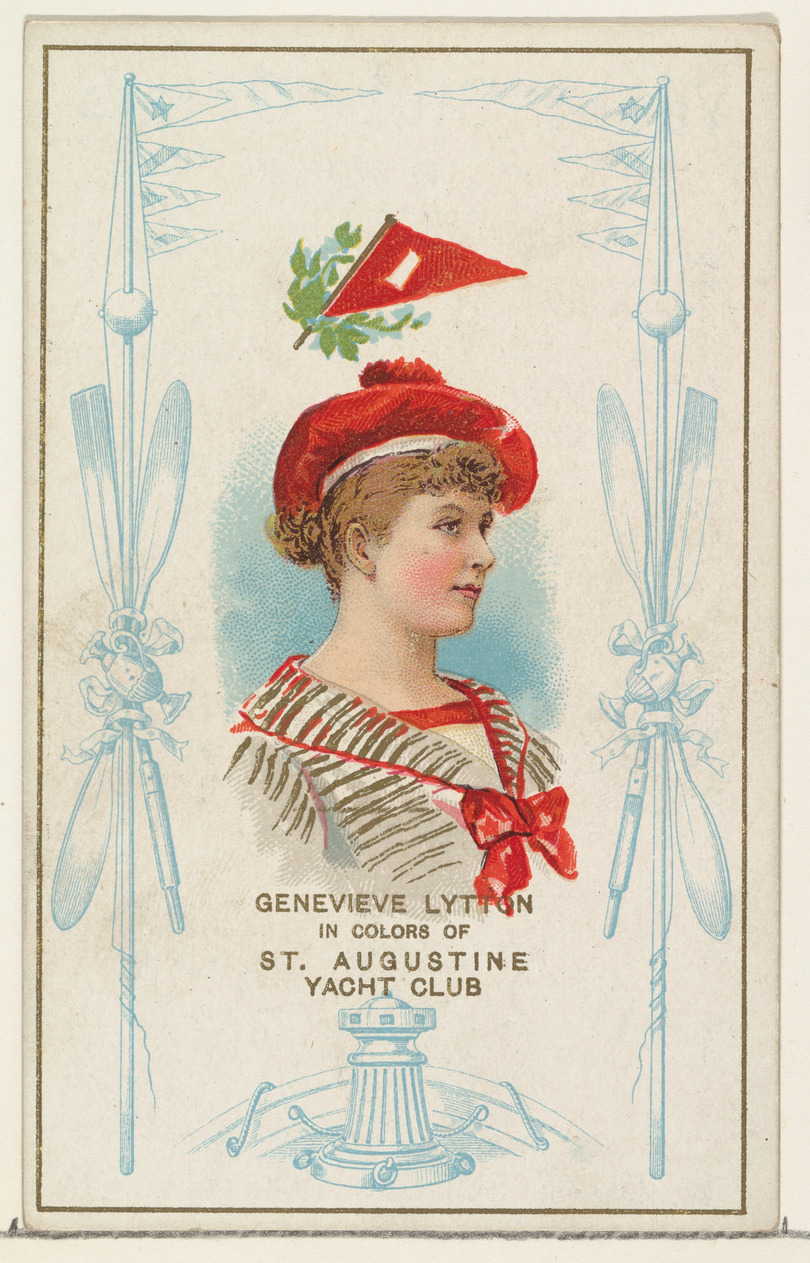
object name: print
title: Genevieve Lytton in Colors of St. Augustine Yacht Club, from the Yacht Colors of the World series (N140) issued by Duke Sons & Co. to promote Honest Long Cut Tobacco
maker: w. duke, sons & co.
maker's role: publisher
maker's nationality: american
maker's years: 1870-1920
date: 1890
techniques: color lithograph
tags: profiles,women,flags